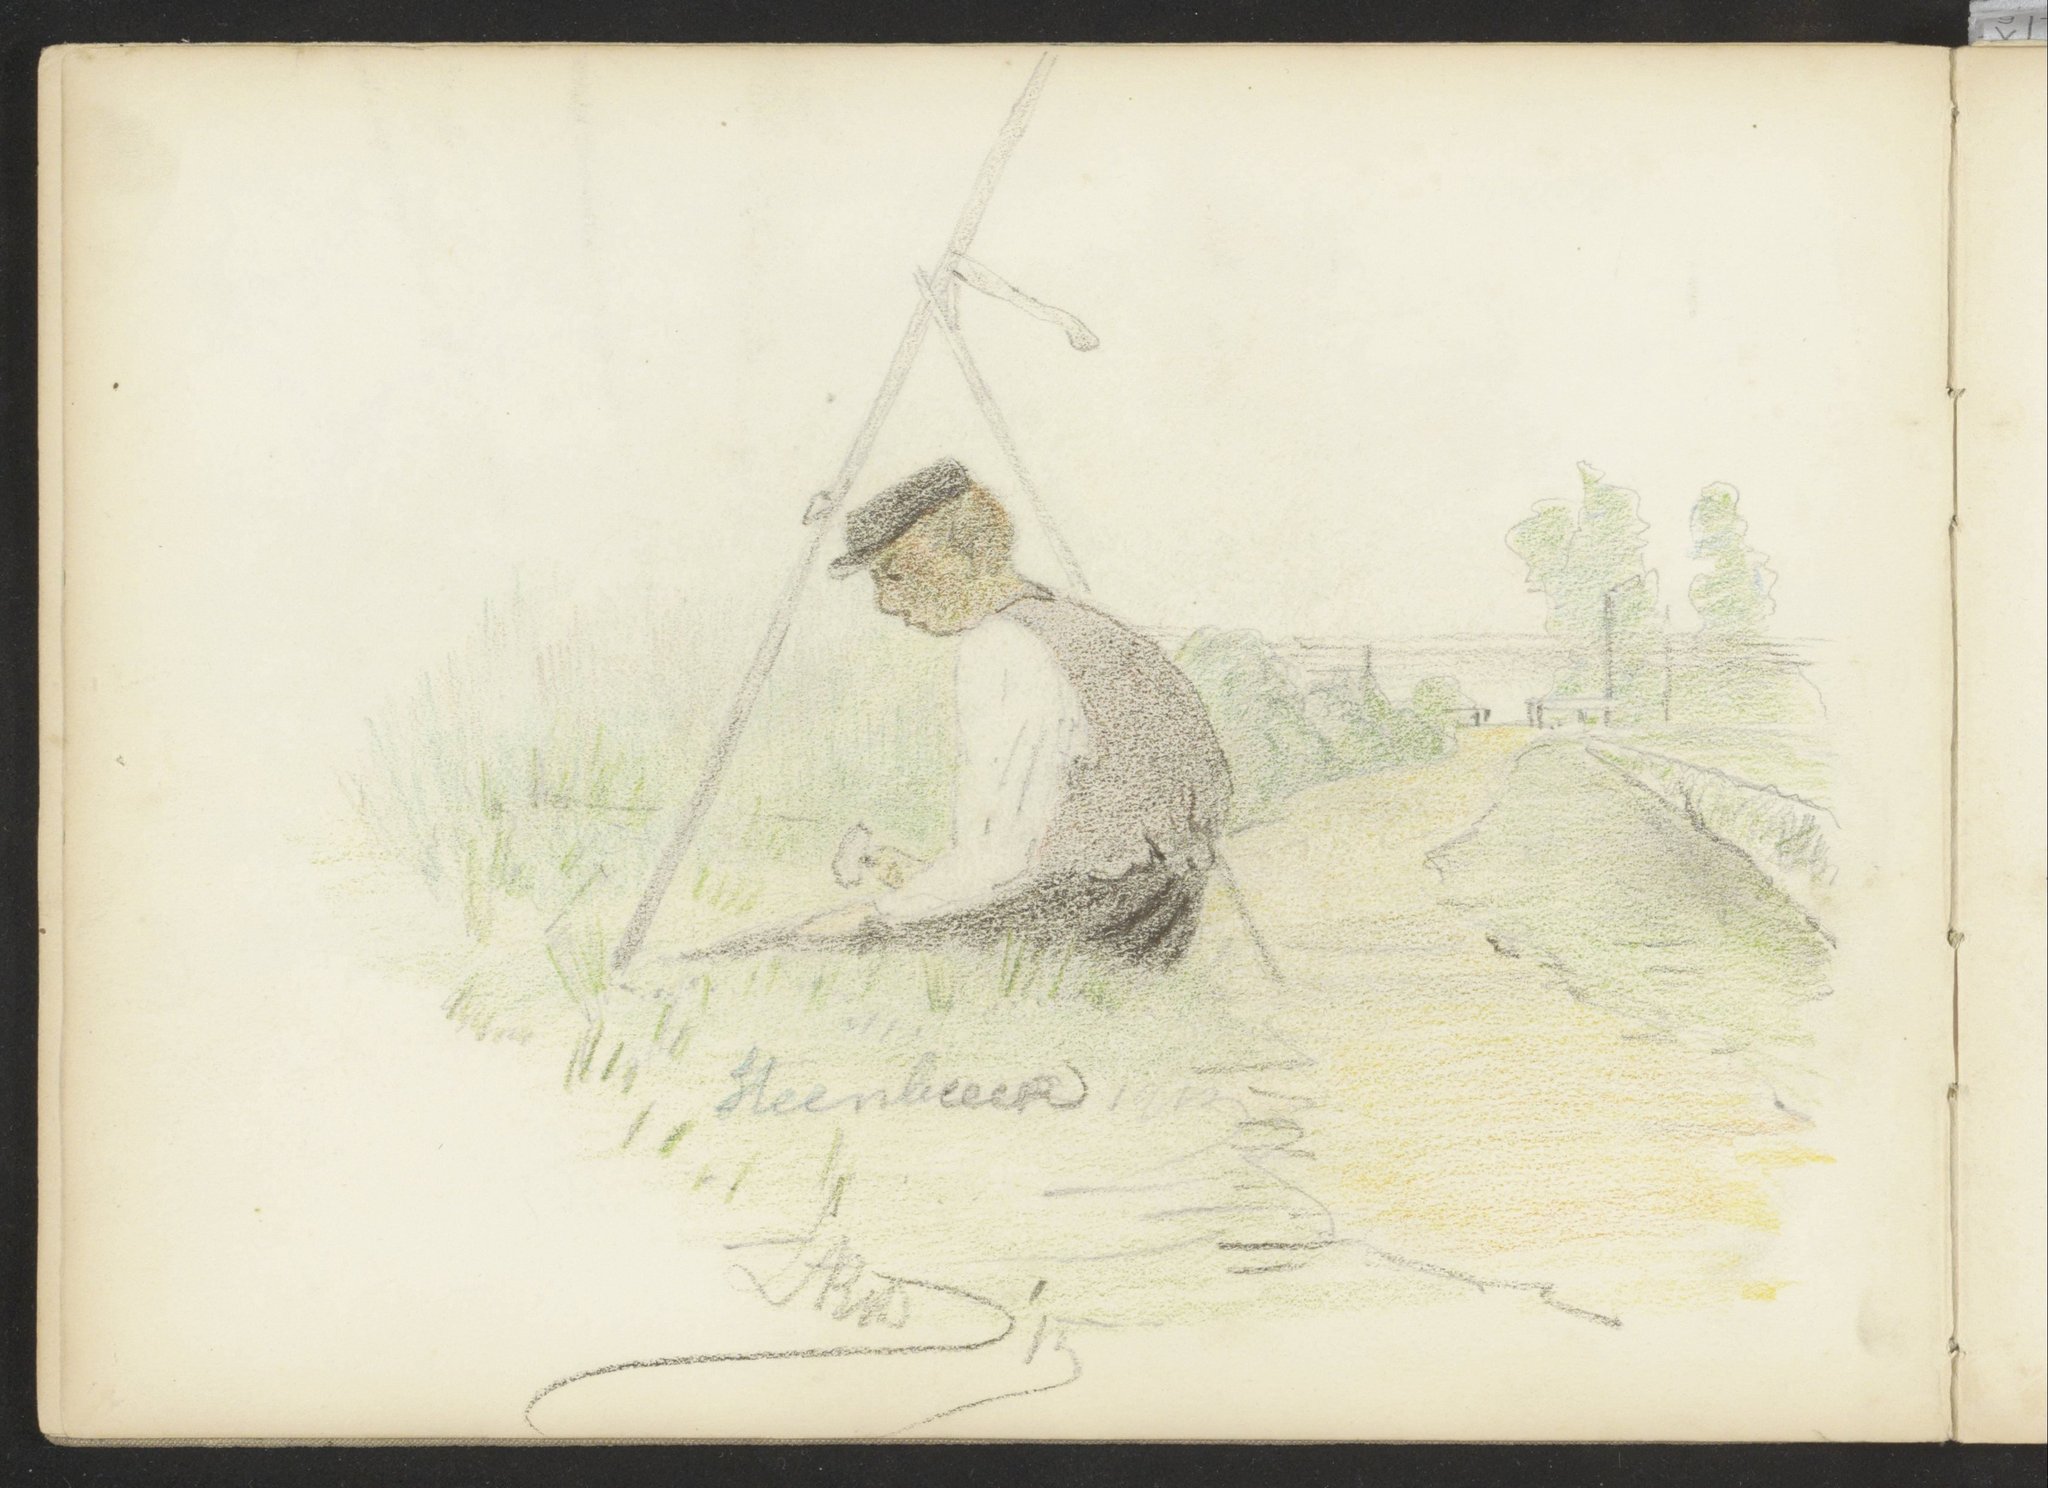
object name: sketchbook leaf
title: Zittende jongen bij een pad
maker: jonkheer johannes ludovicus paulus bosch van drakestein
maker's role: draughtsman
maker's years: 1865-1929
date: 1915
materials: chalk, paper, pencil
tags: head (human), landscapes (+ landscape with figures, staffage)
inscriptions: signature and date: ‘19[...]/ LBvD '15’, annotation: ‘Heenkeer’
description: Blad 4 verso uit een schetsboek met 47 bladen.